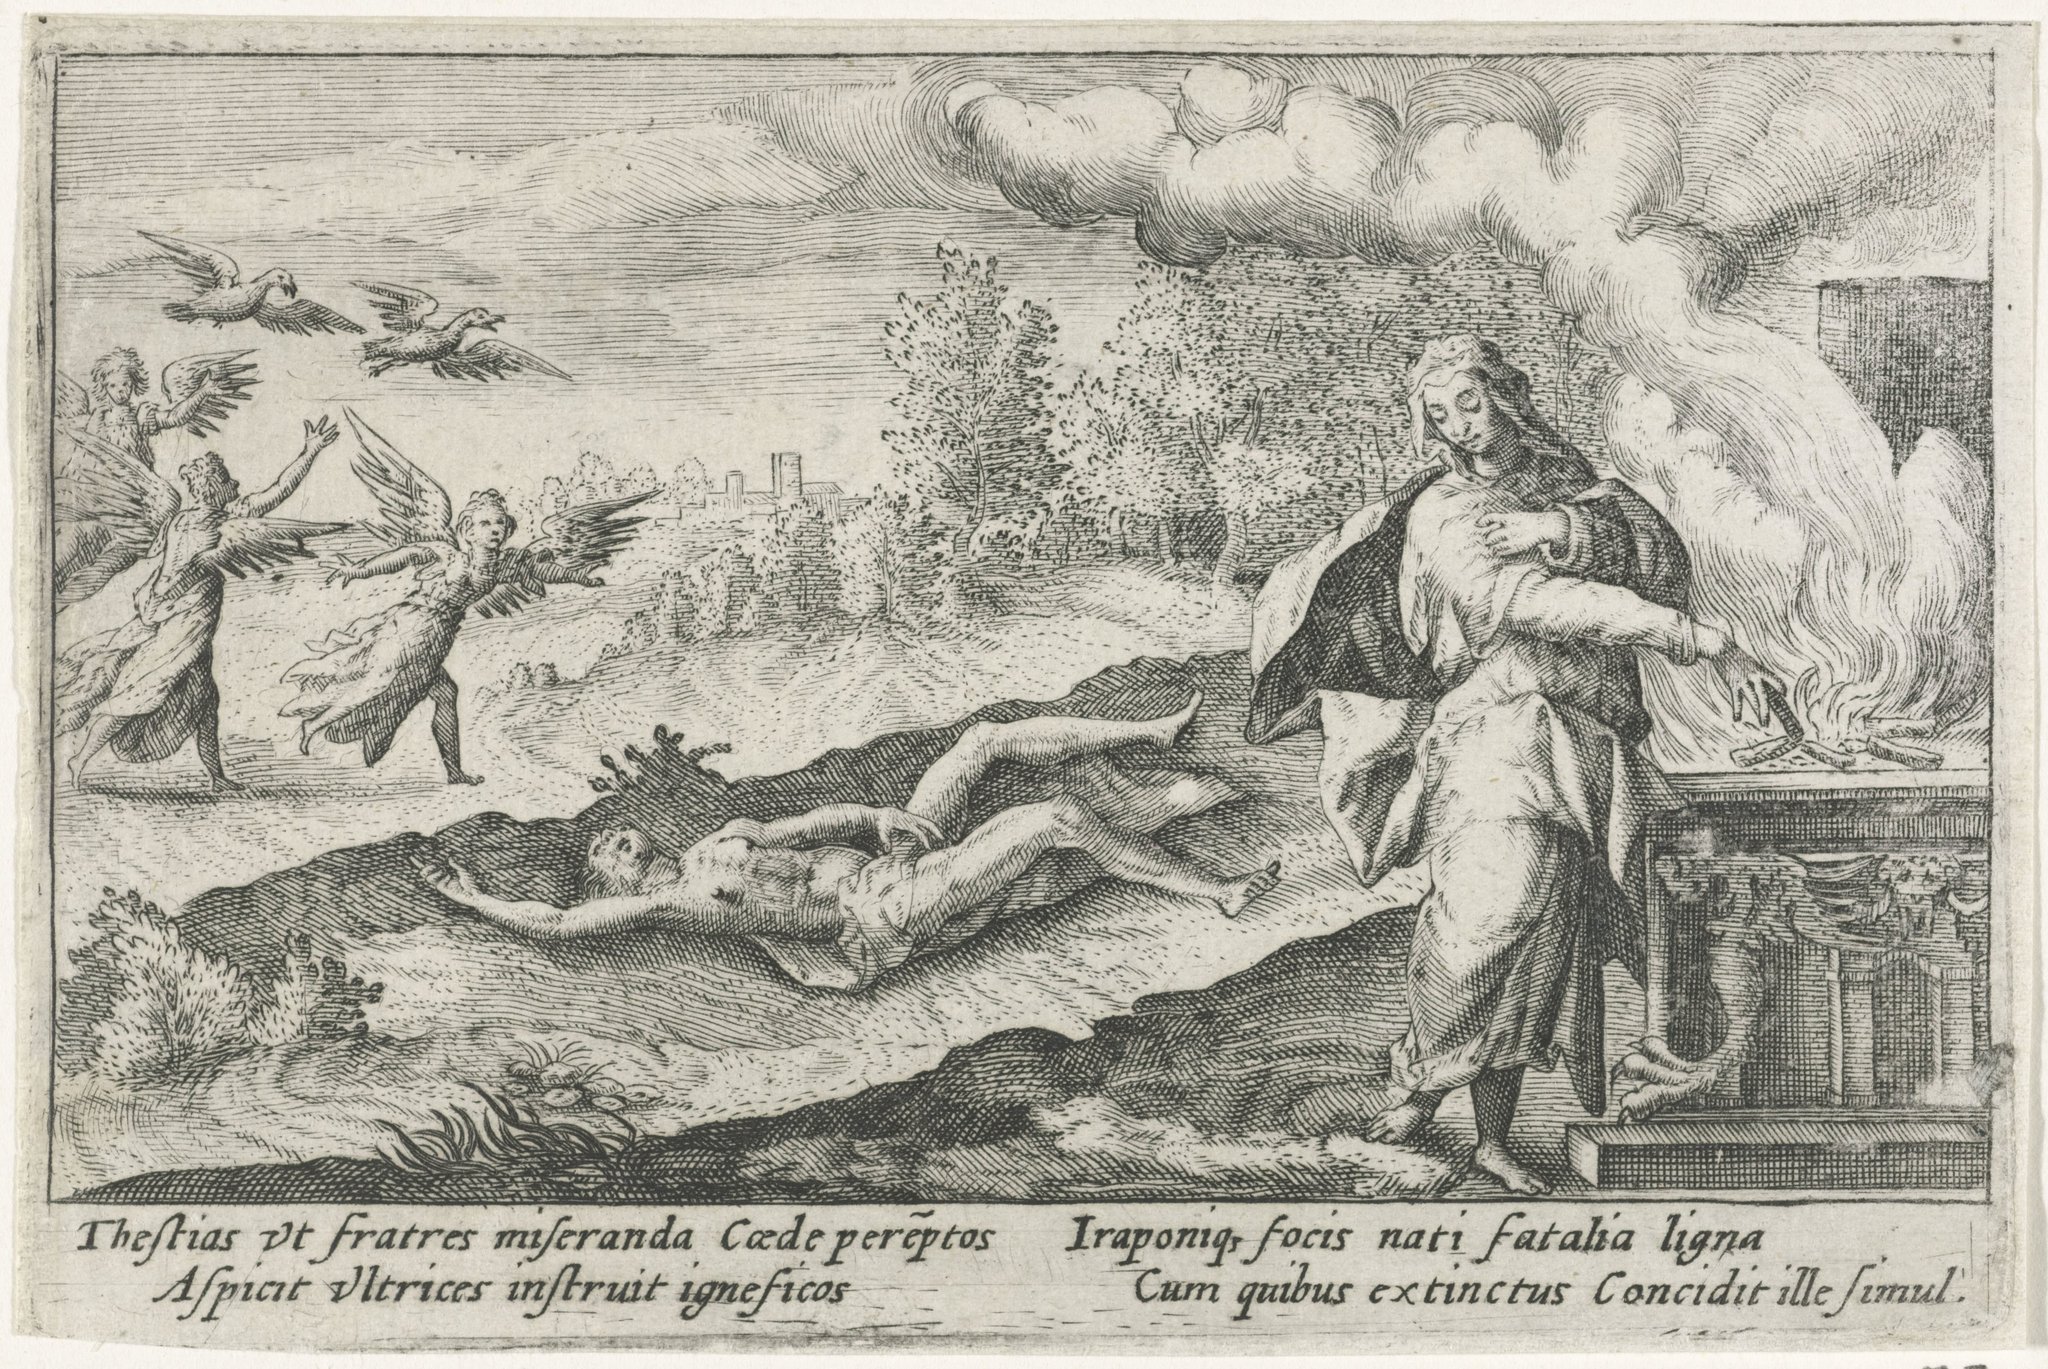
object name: print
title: Metamorfosen van Ovidius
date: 1602-1607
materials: paper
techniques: engraving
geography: cologne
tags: death of meleager: althaea throws the unburnt brand into the fire, thus causing meleager's death, meleager's sisters changed into guinea-hens: while meleager's sisters grieve at meleager's death, they are changed into guinea-hens (meleagrides) by diana (ovid, metamorphoses viii 539)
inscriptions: collector's mark: Lugt 2228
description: Althaea doodt haar zoon Meleager door een tak op het vuur te gooien. De Furiën hadden bij de geboorte van haar zoon voorspeld dat hij dezelfde levensduur zou hebben als die tak. Links op de achtergrond de zussen van Meleager die rouwen, Diana gaf hen vleugels. In de marge een vierregelig onderschrift, in twee kolommen, in het Latijn.